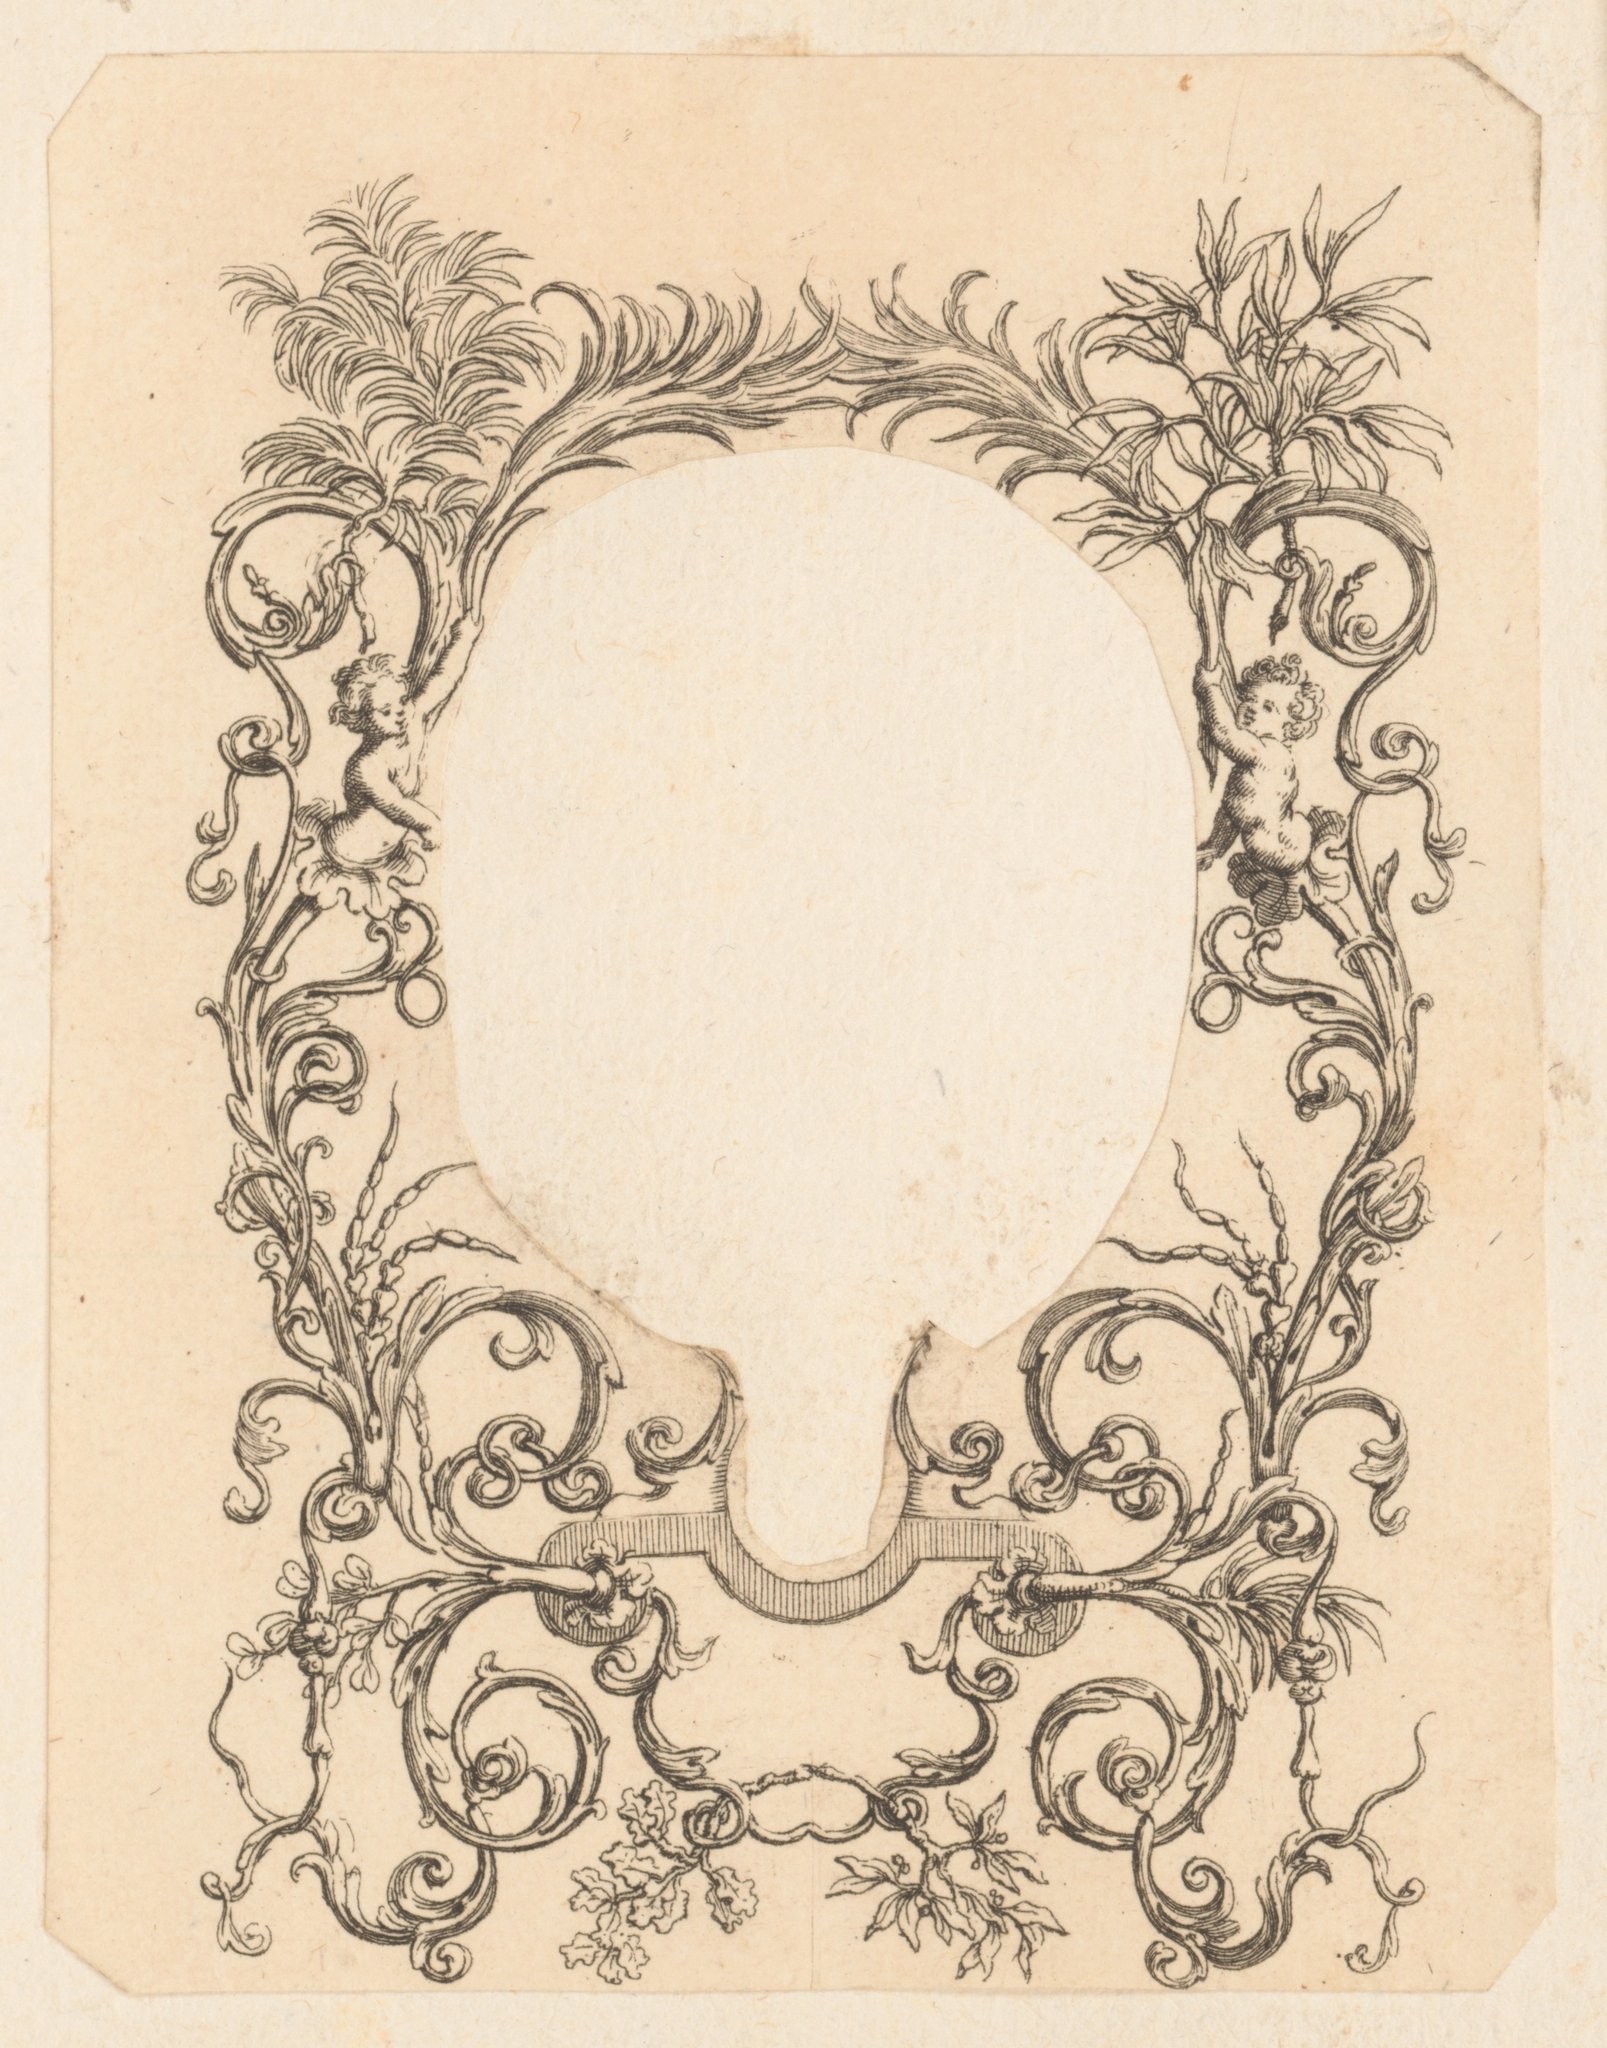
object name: print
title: Ornamental Frame with Garlands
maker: anonymous, 18th century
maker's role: artist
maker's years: 1700-1800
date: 1701-1800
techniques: etching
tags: garlands